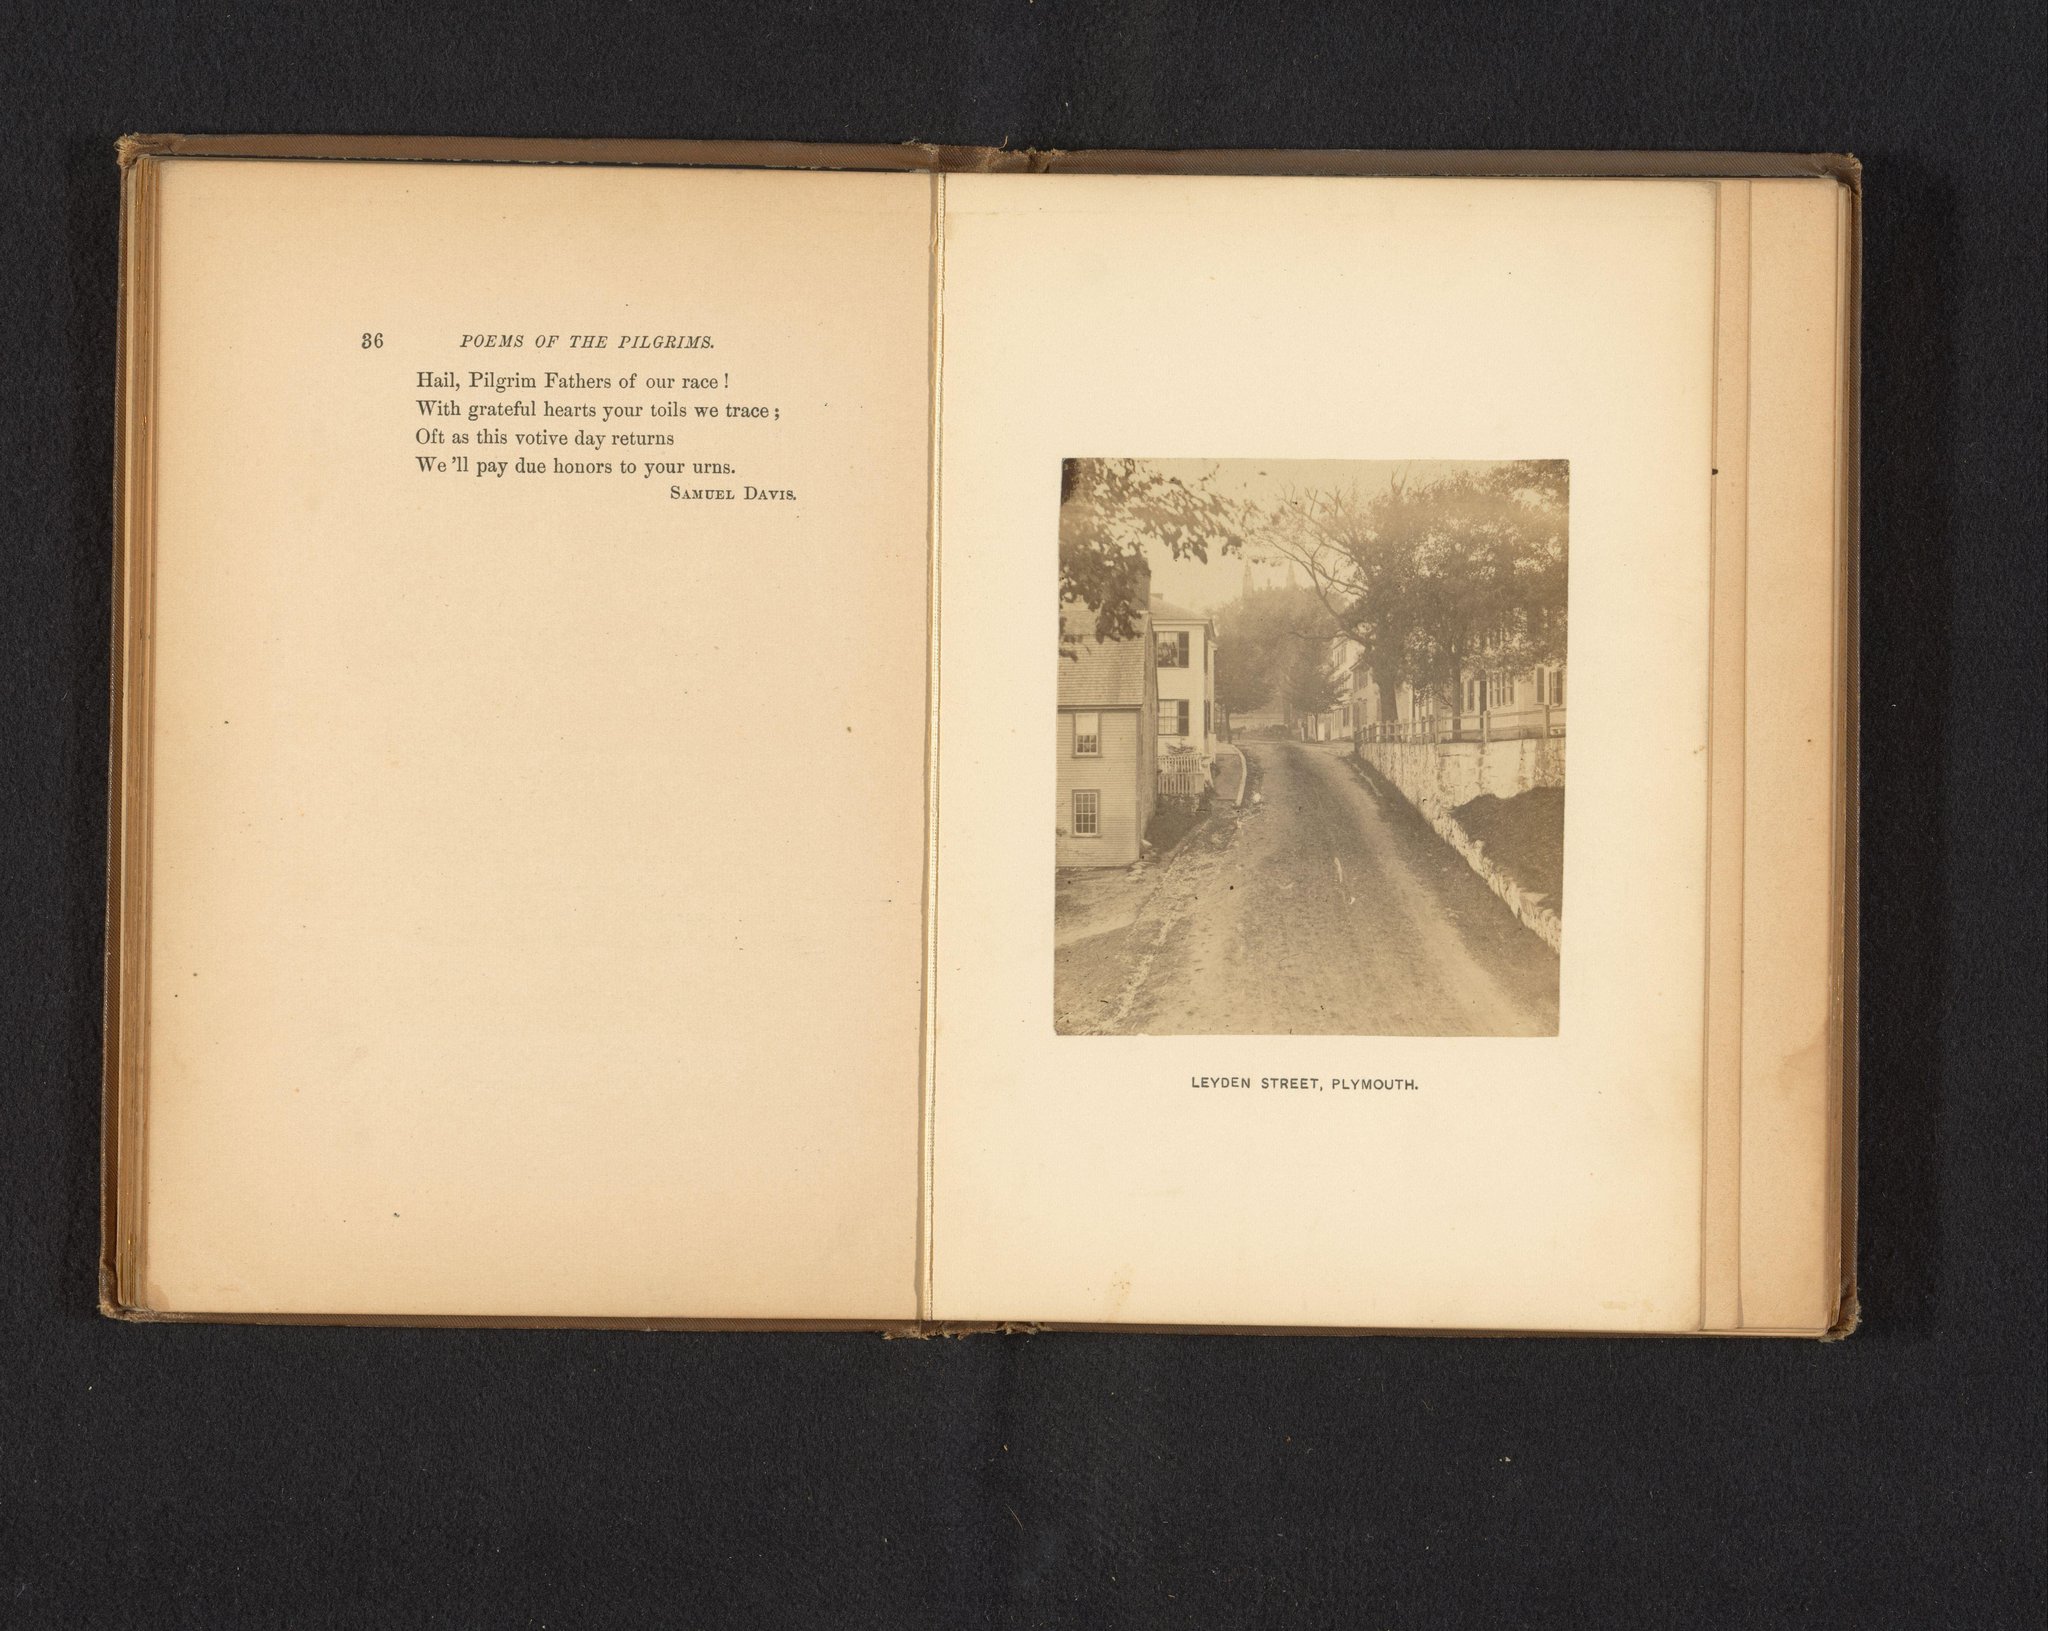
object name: page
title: Leyden Street, Plymouth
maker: Anonymous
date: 1881-1886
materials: photographic support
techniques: albumen print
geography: leyden street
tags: street